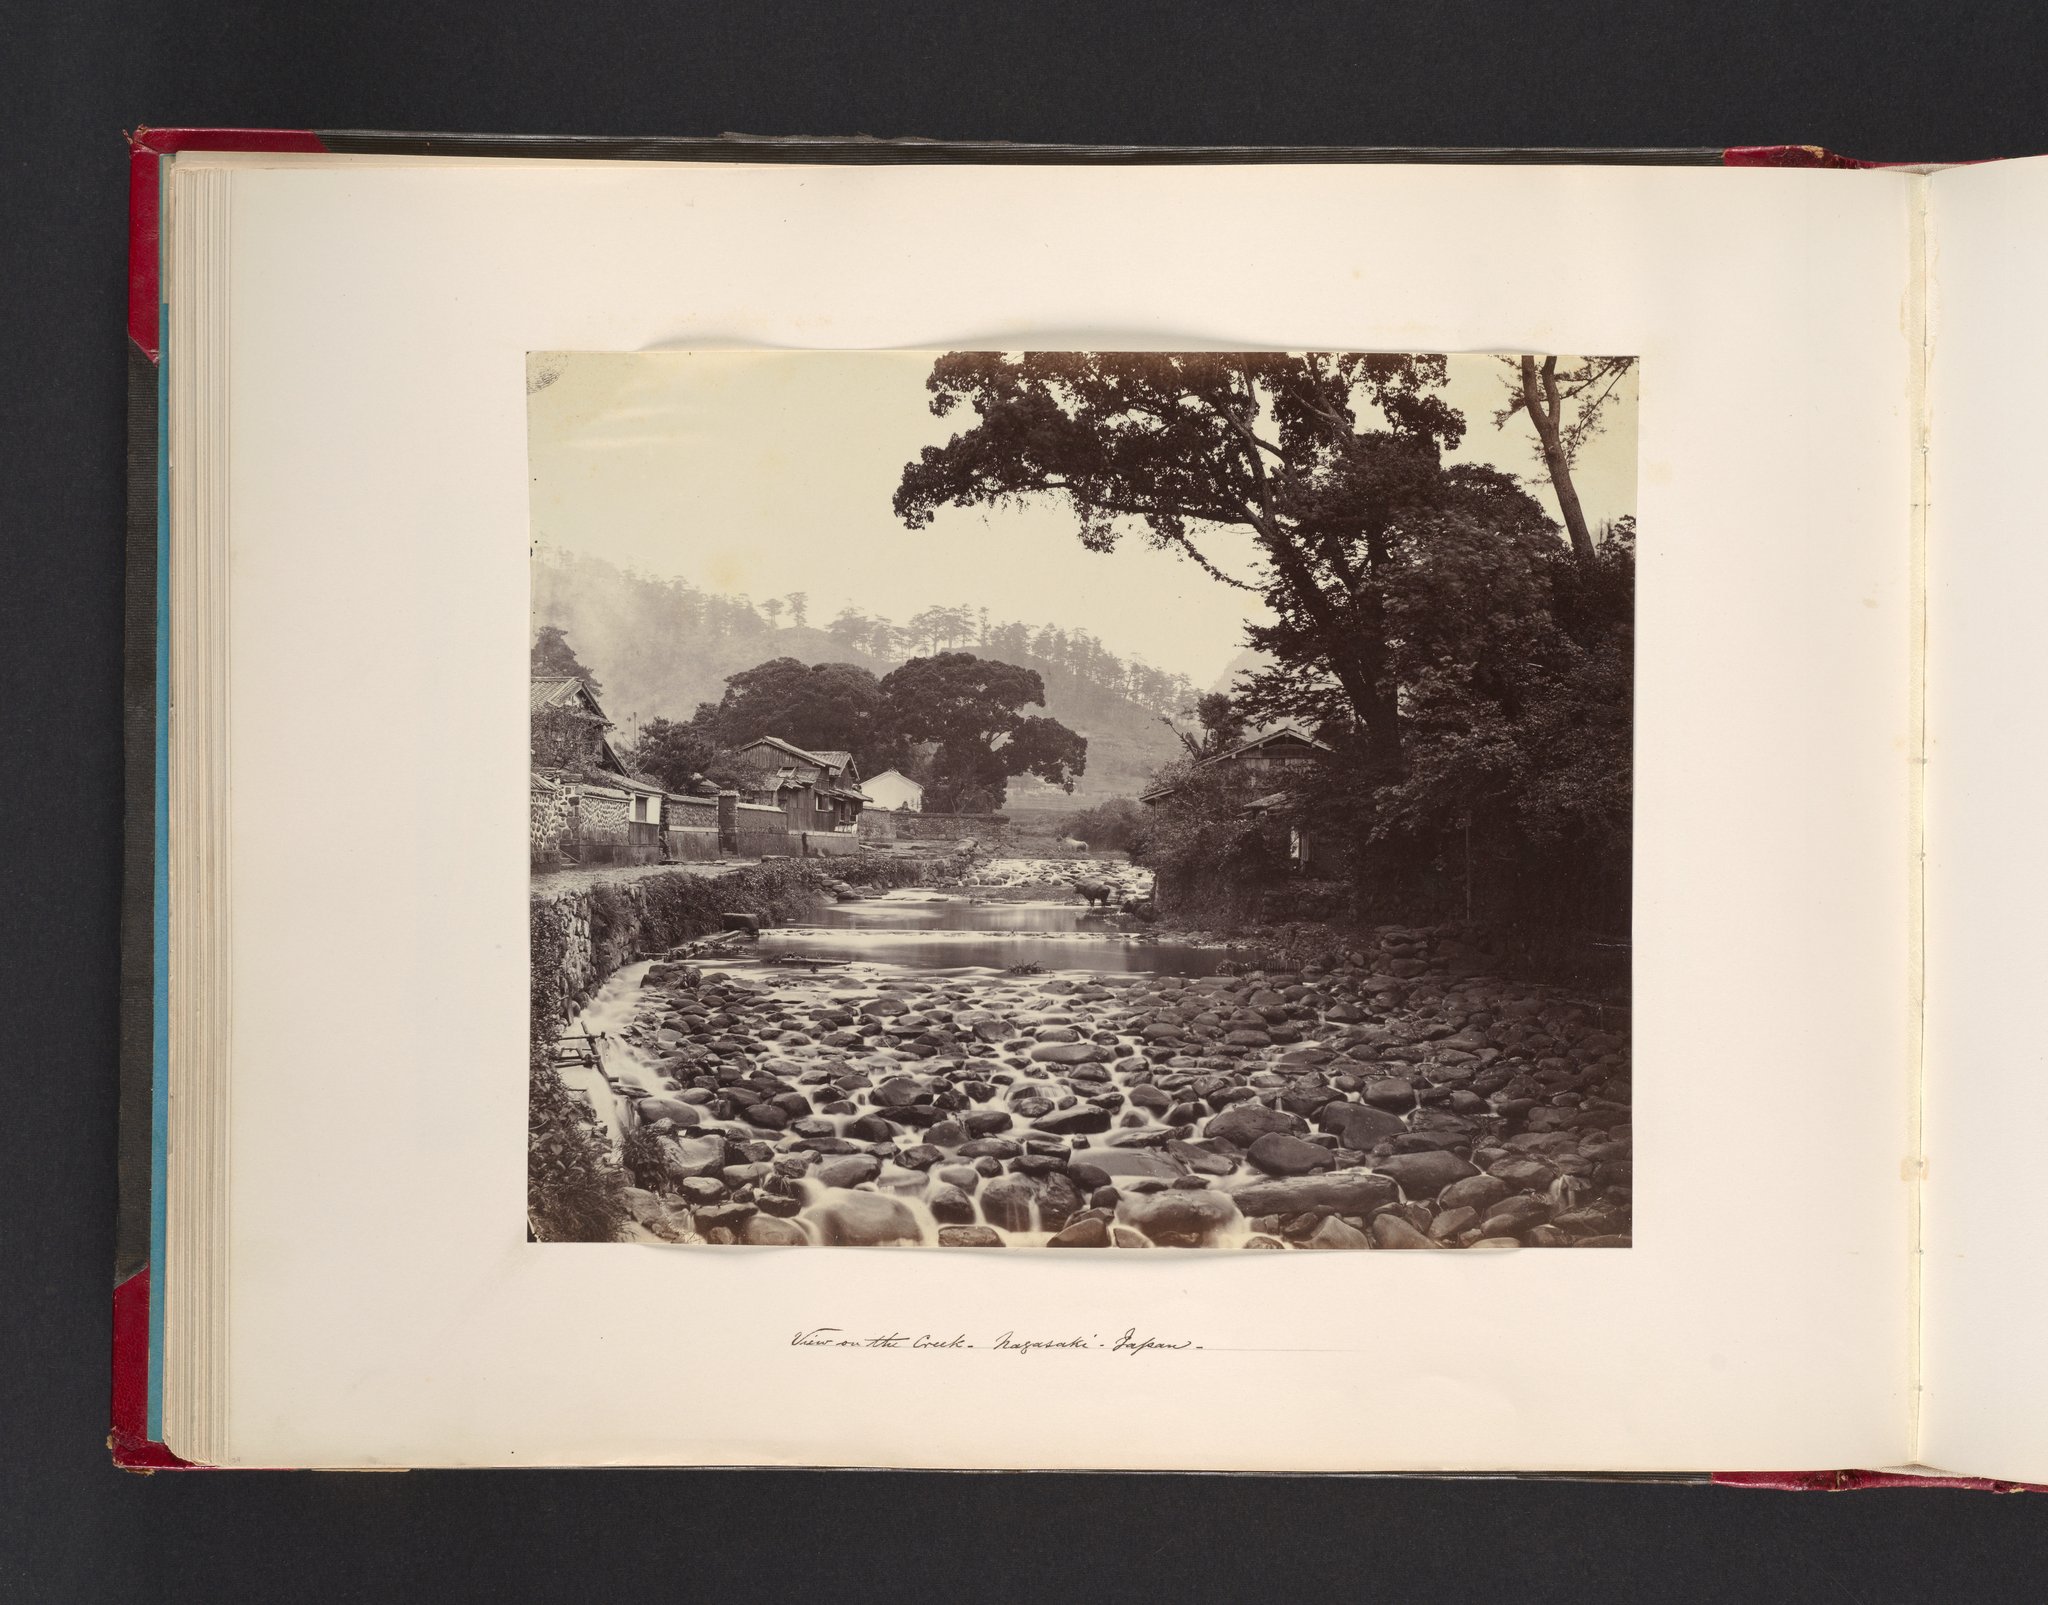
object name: photograph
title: View on the Creek, Nagasaki, Japan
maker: john thomson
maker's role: artist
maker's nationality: british, scottish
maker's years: 1837-1921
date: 1865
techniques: albumen silver print, glass negative